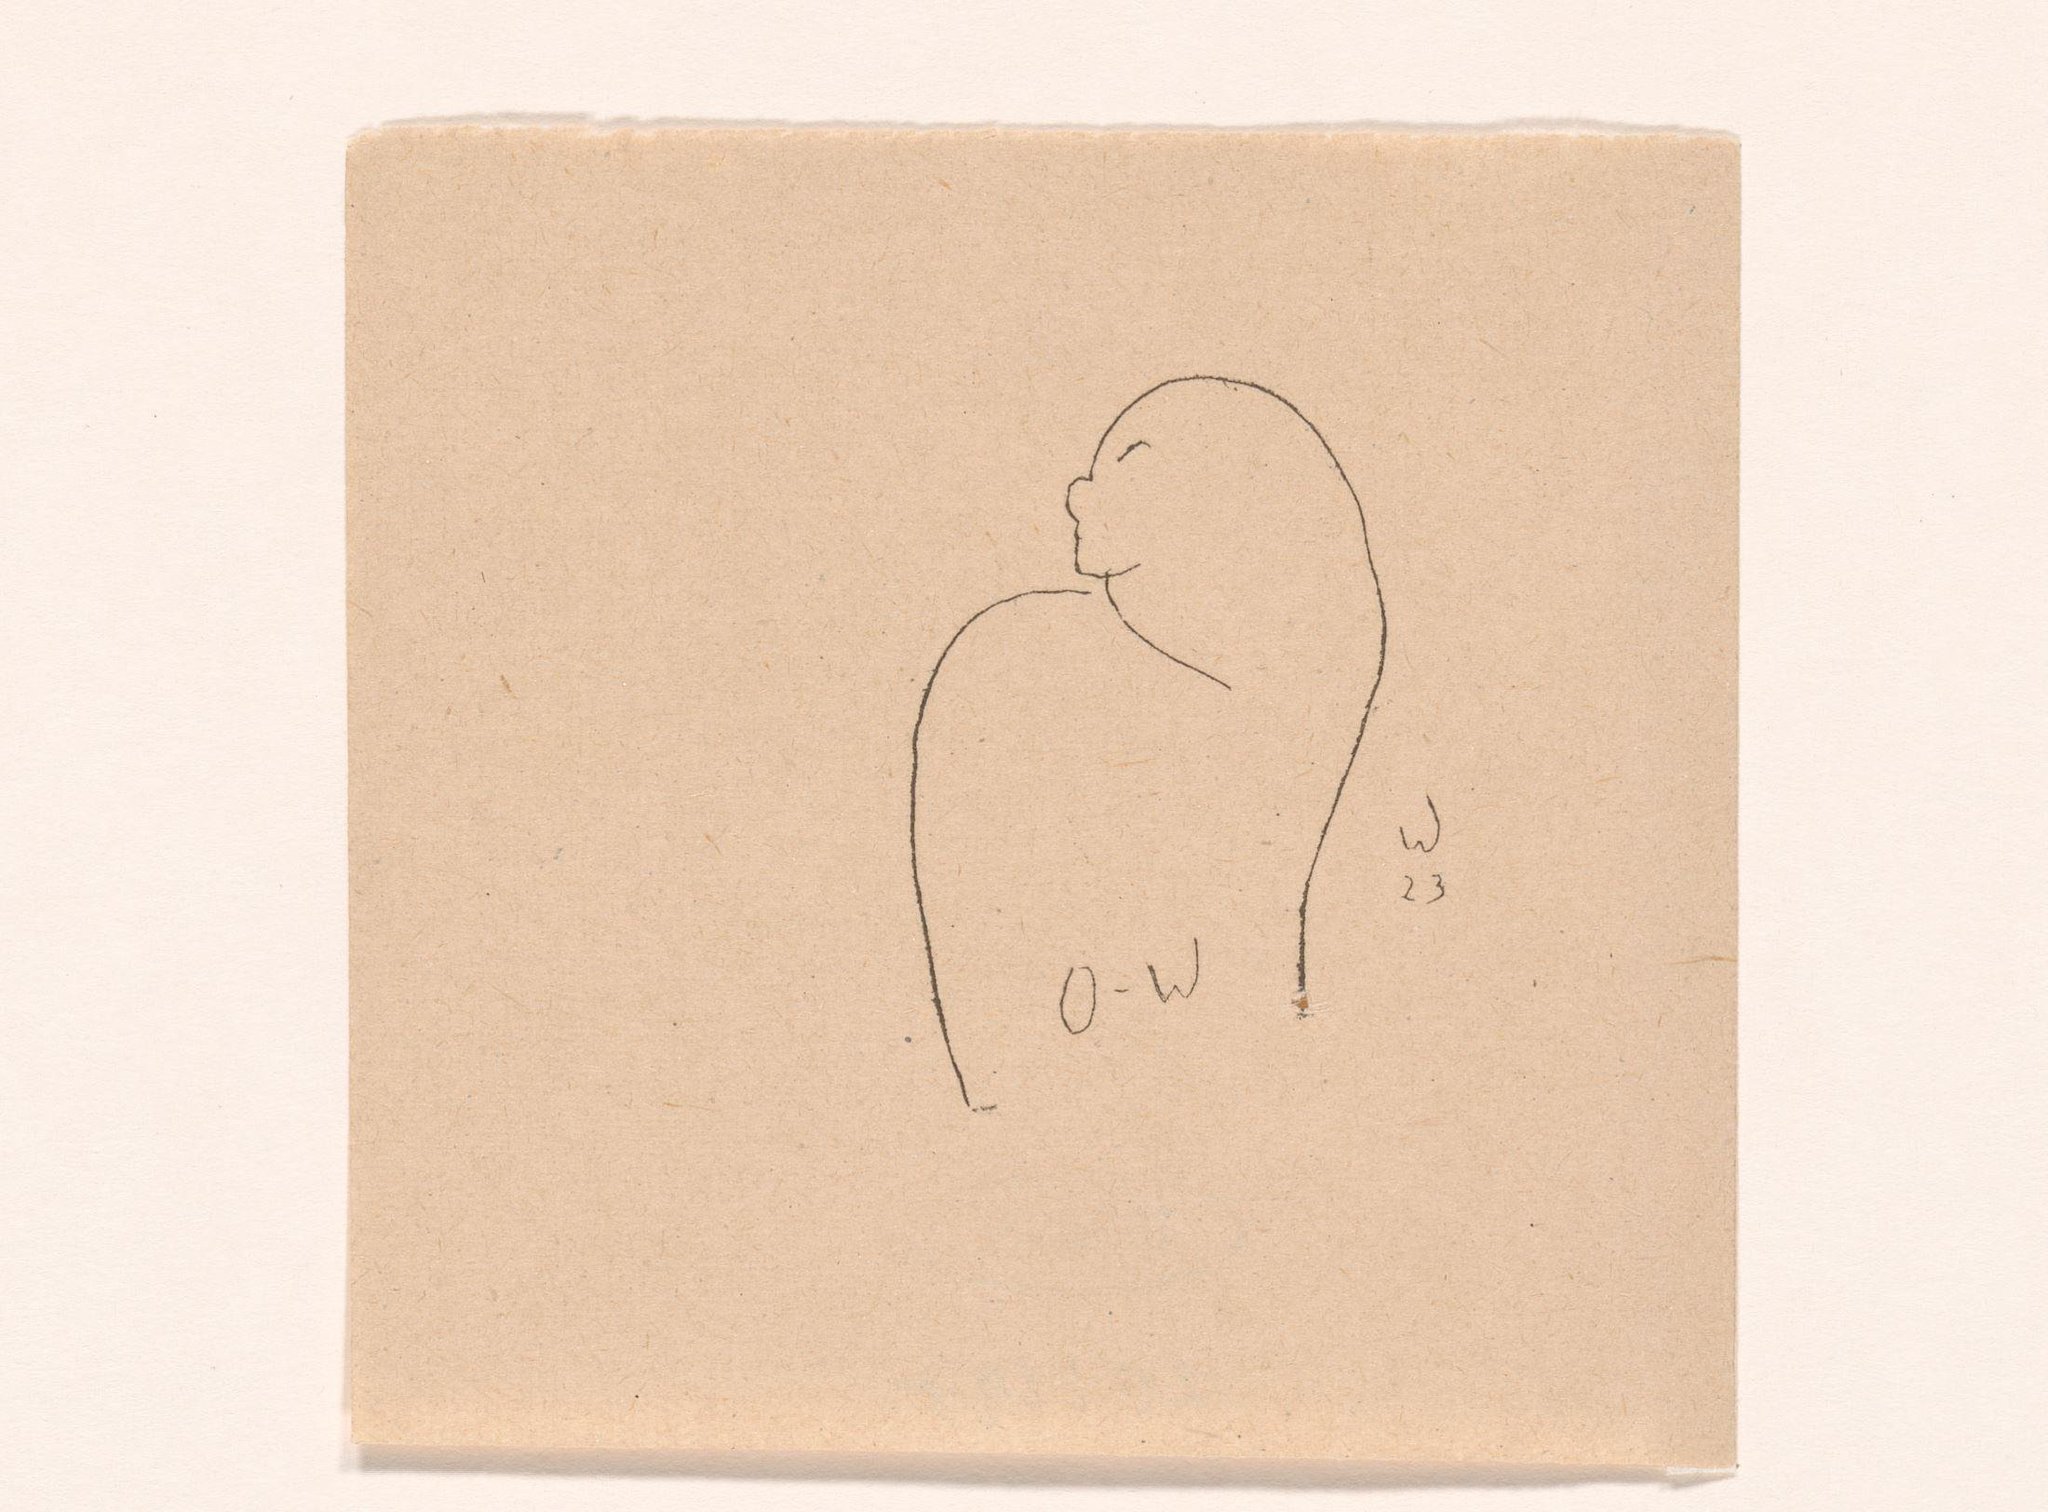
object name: print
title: Idealisten II en verdere Kanttekeningen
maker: erich wichmann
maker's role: print maker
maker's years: 1890-1929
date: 1923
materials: paper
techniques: lithograph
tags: caricatures (human types)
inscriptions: collector's mark: Lugt 2228